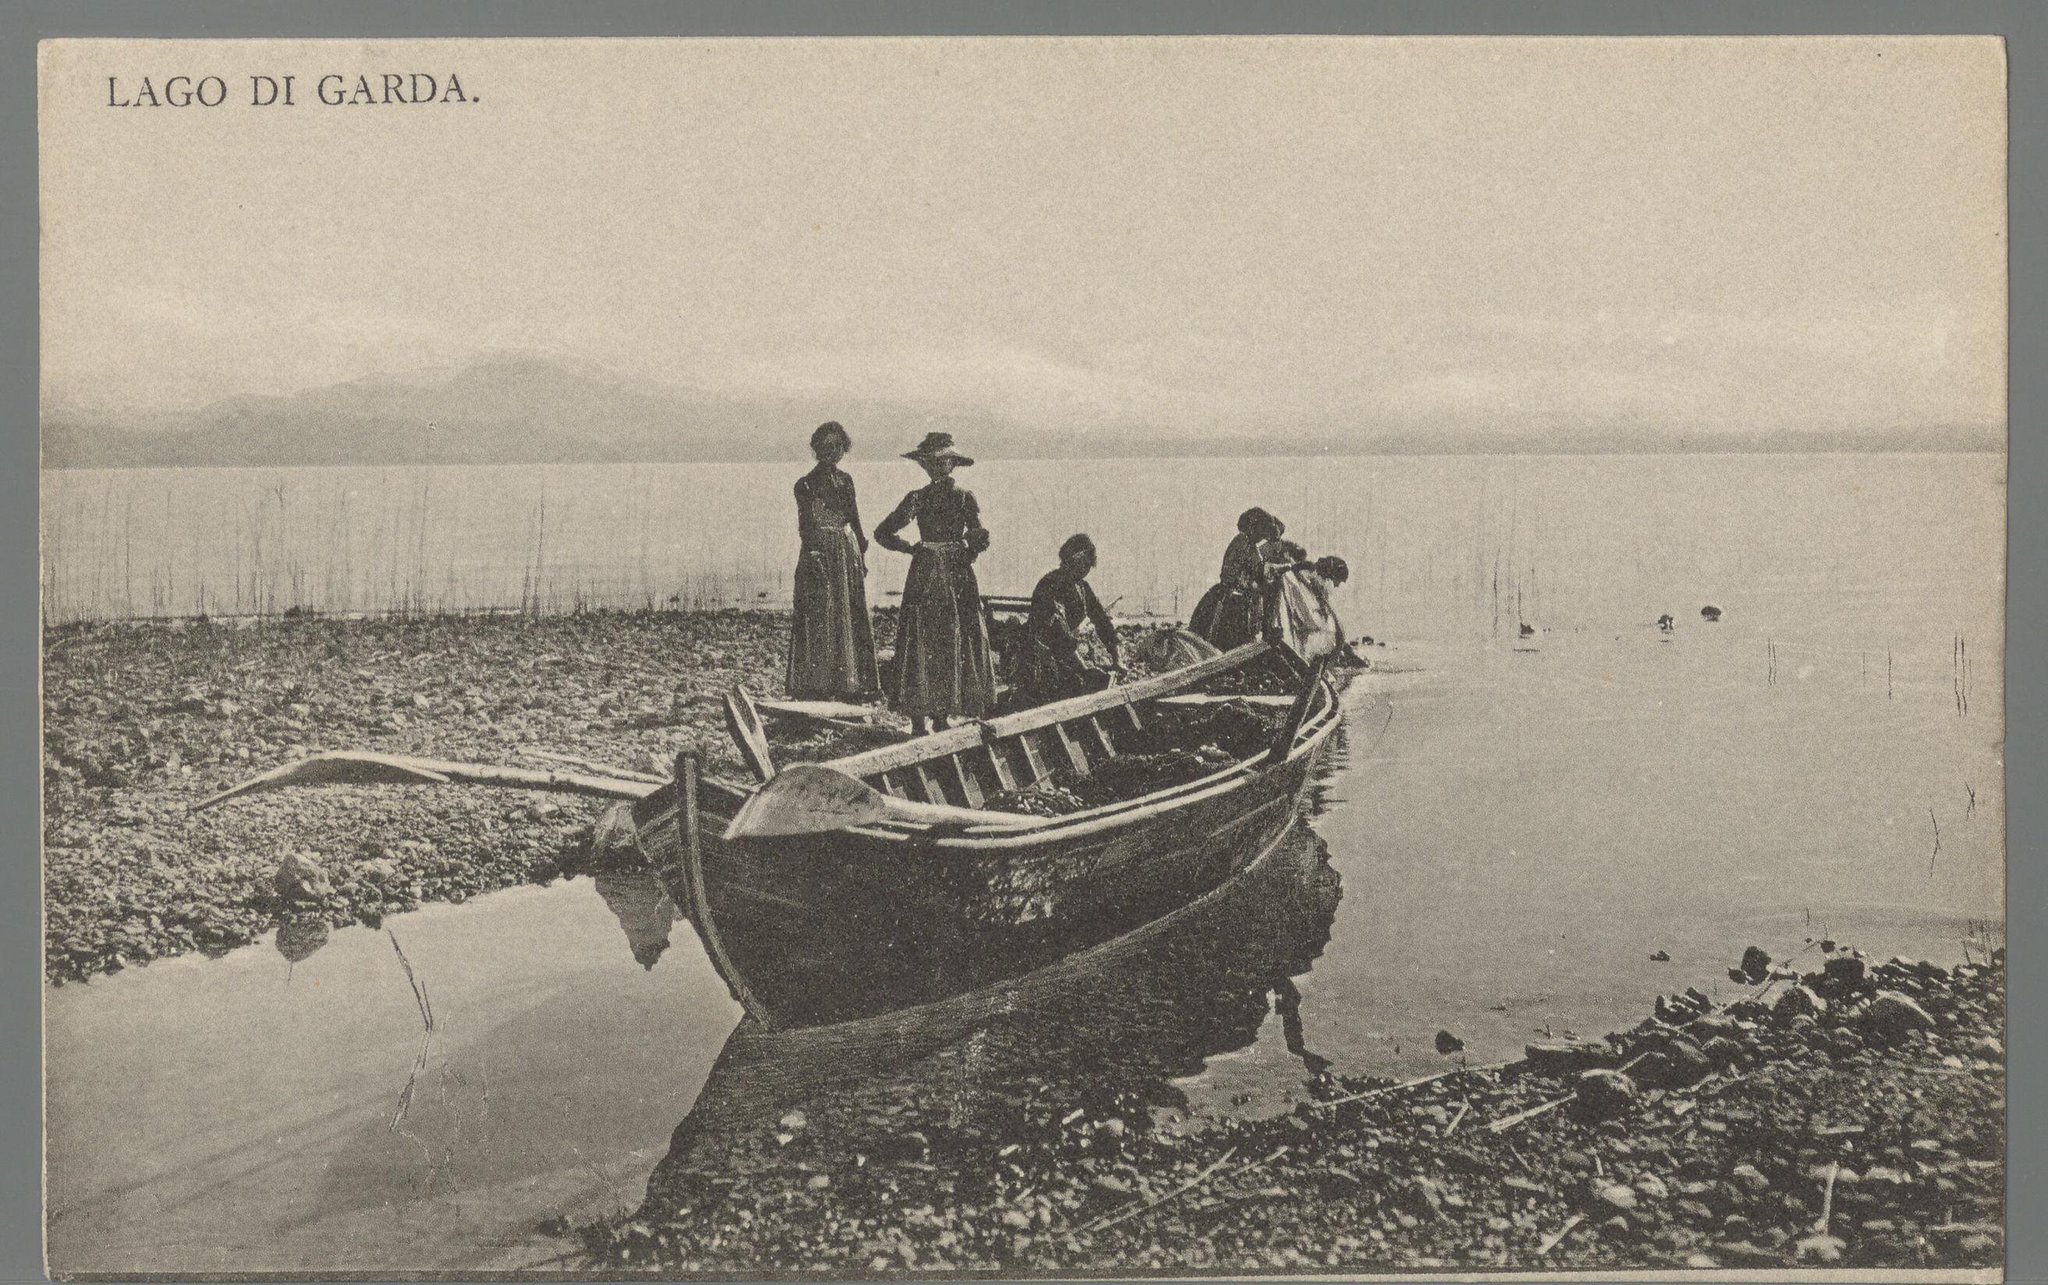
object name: ansichtkaart, prentbriefkaart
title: Lago di Garda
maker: Anonymous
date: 1906-1930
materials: cardboard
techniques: photograph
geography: salò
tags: rowing-boat, canoe, etc. (+ four persons or more ~ traffic and transport), lake, mountains